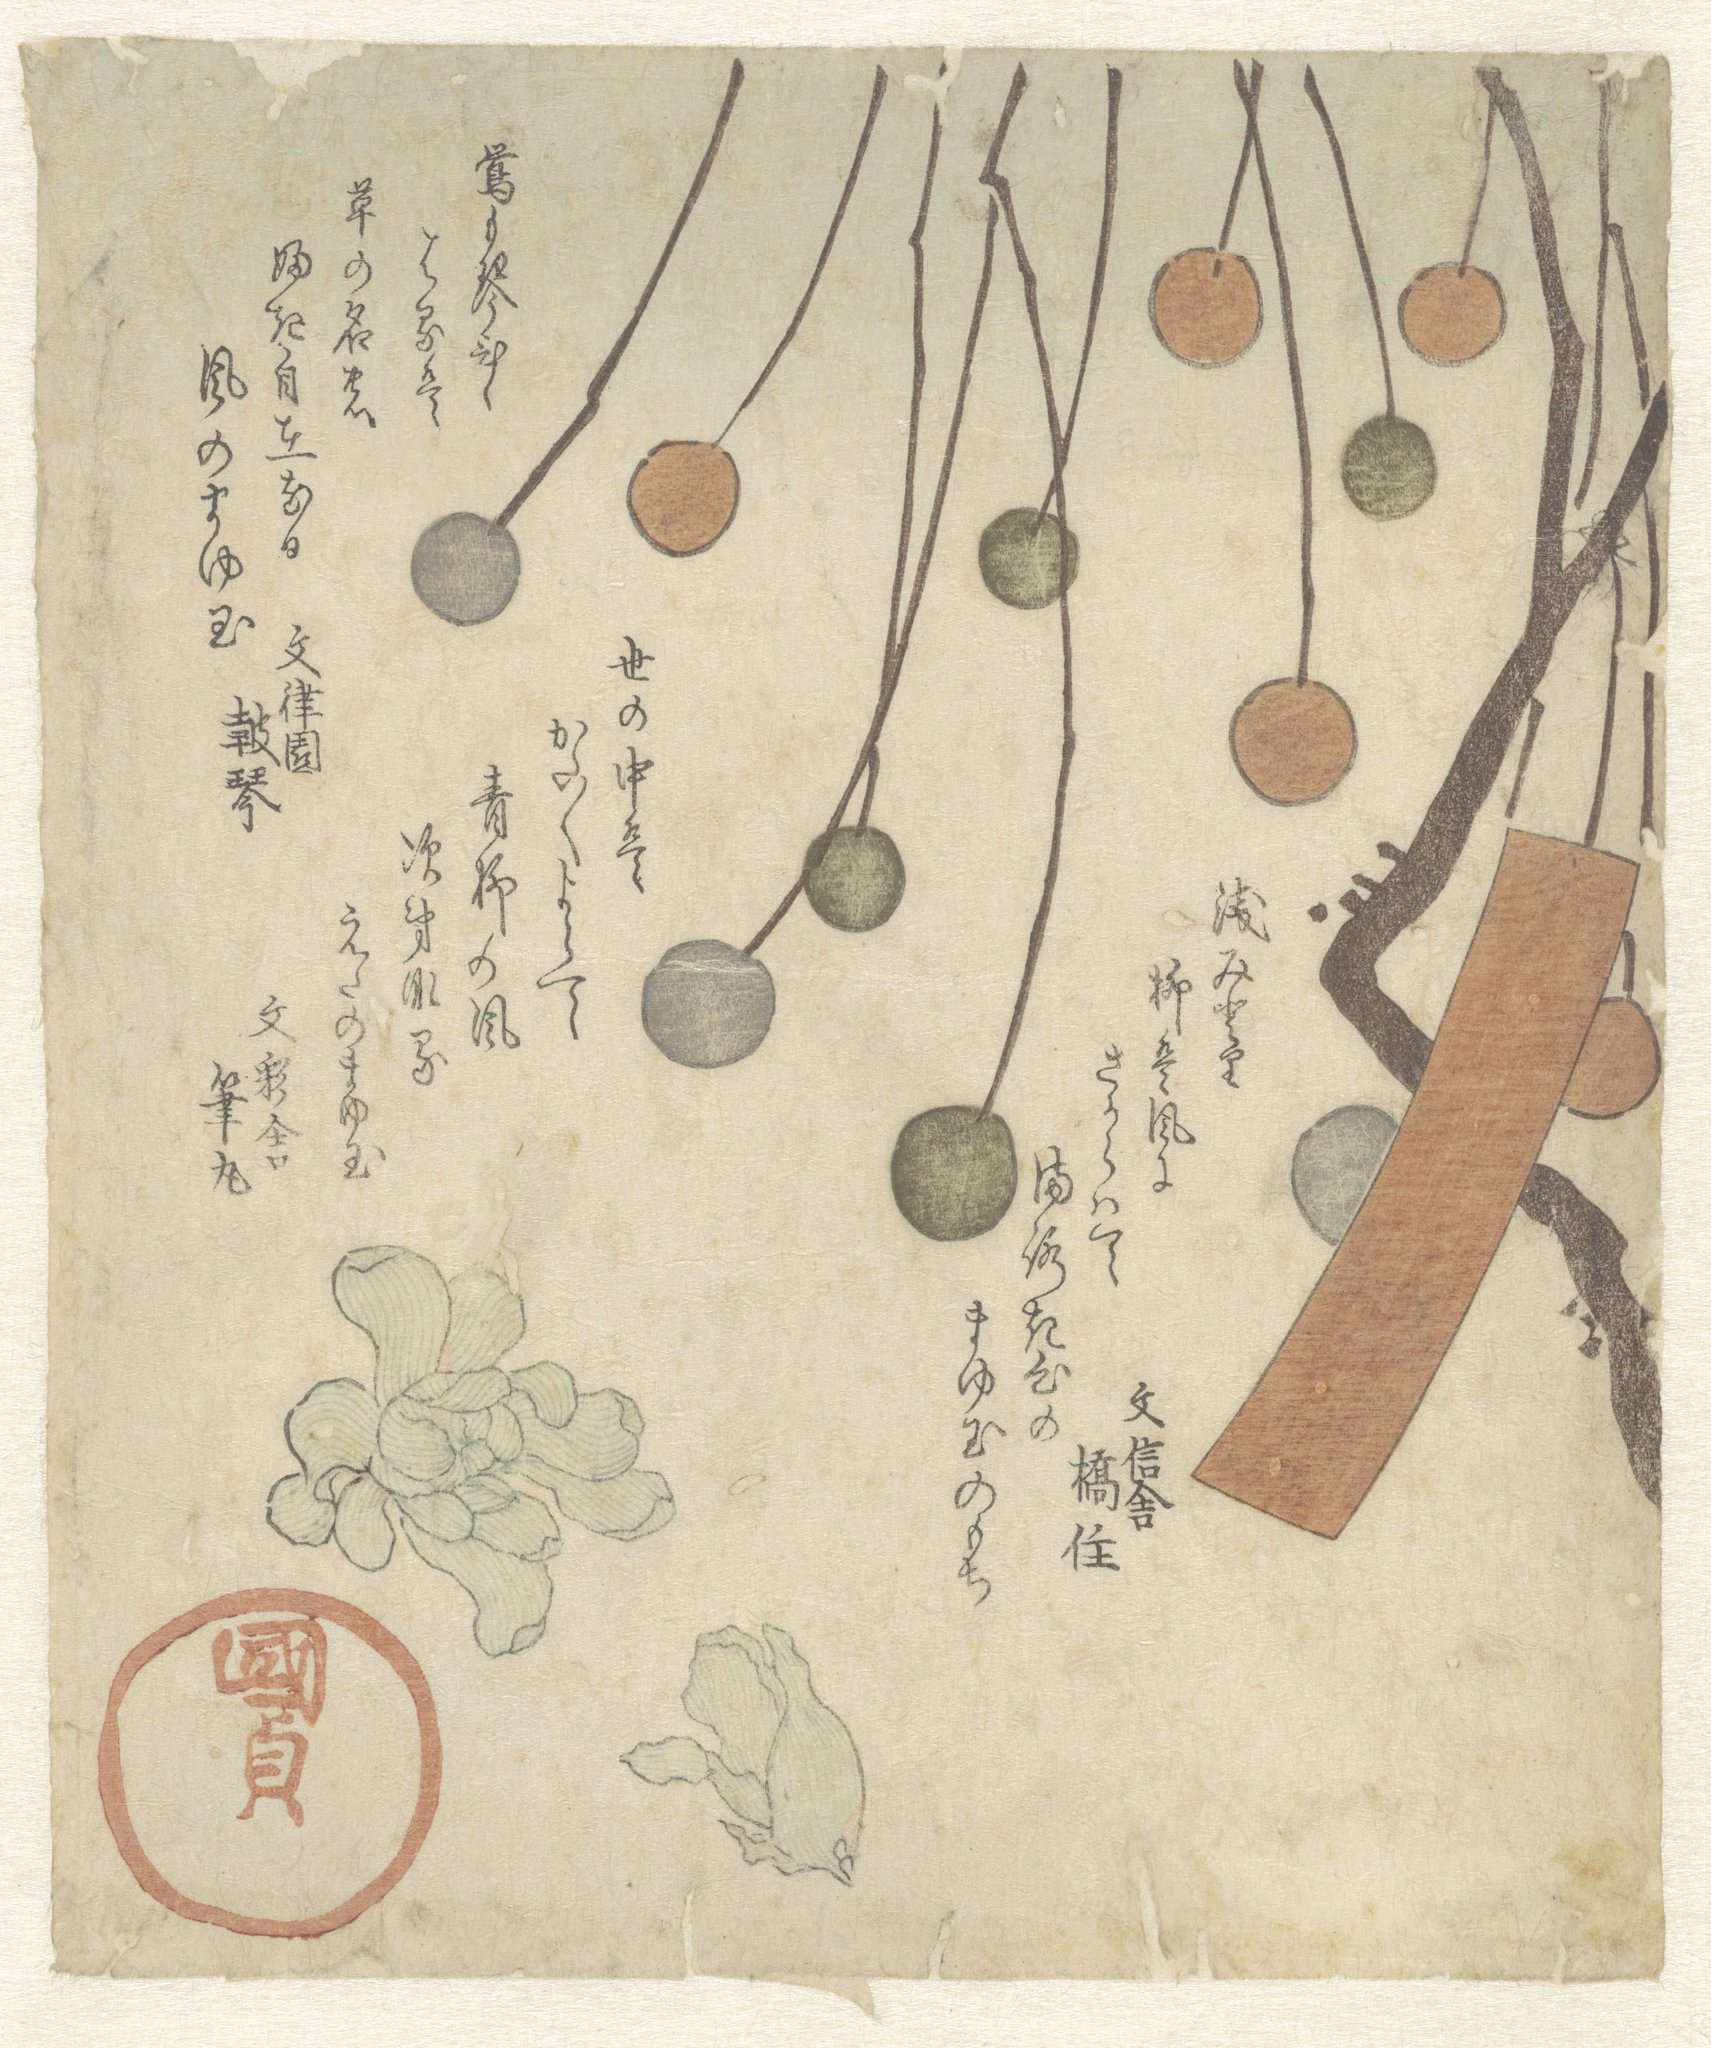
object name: surimono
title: Snoep rijstballetjes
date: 1820-1830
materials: paper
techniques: woodcut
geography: japan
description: Een surimono is een luxe uitgevoerde prent waarop beeld met één of meerdere gedichten gecombineerd is. Bij het drukken van een surimono werd vaak gebruik gemaakt van dikker papier, blinddruk en metaal pigmenten, zoals koper- en zilverpoeder. De prenten werden vaak in opdracht van dichters gemaakt en als exclusief geschenk aan vrienden en relaties gegeven.